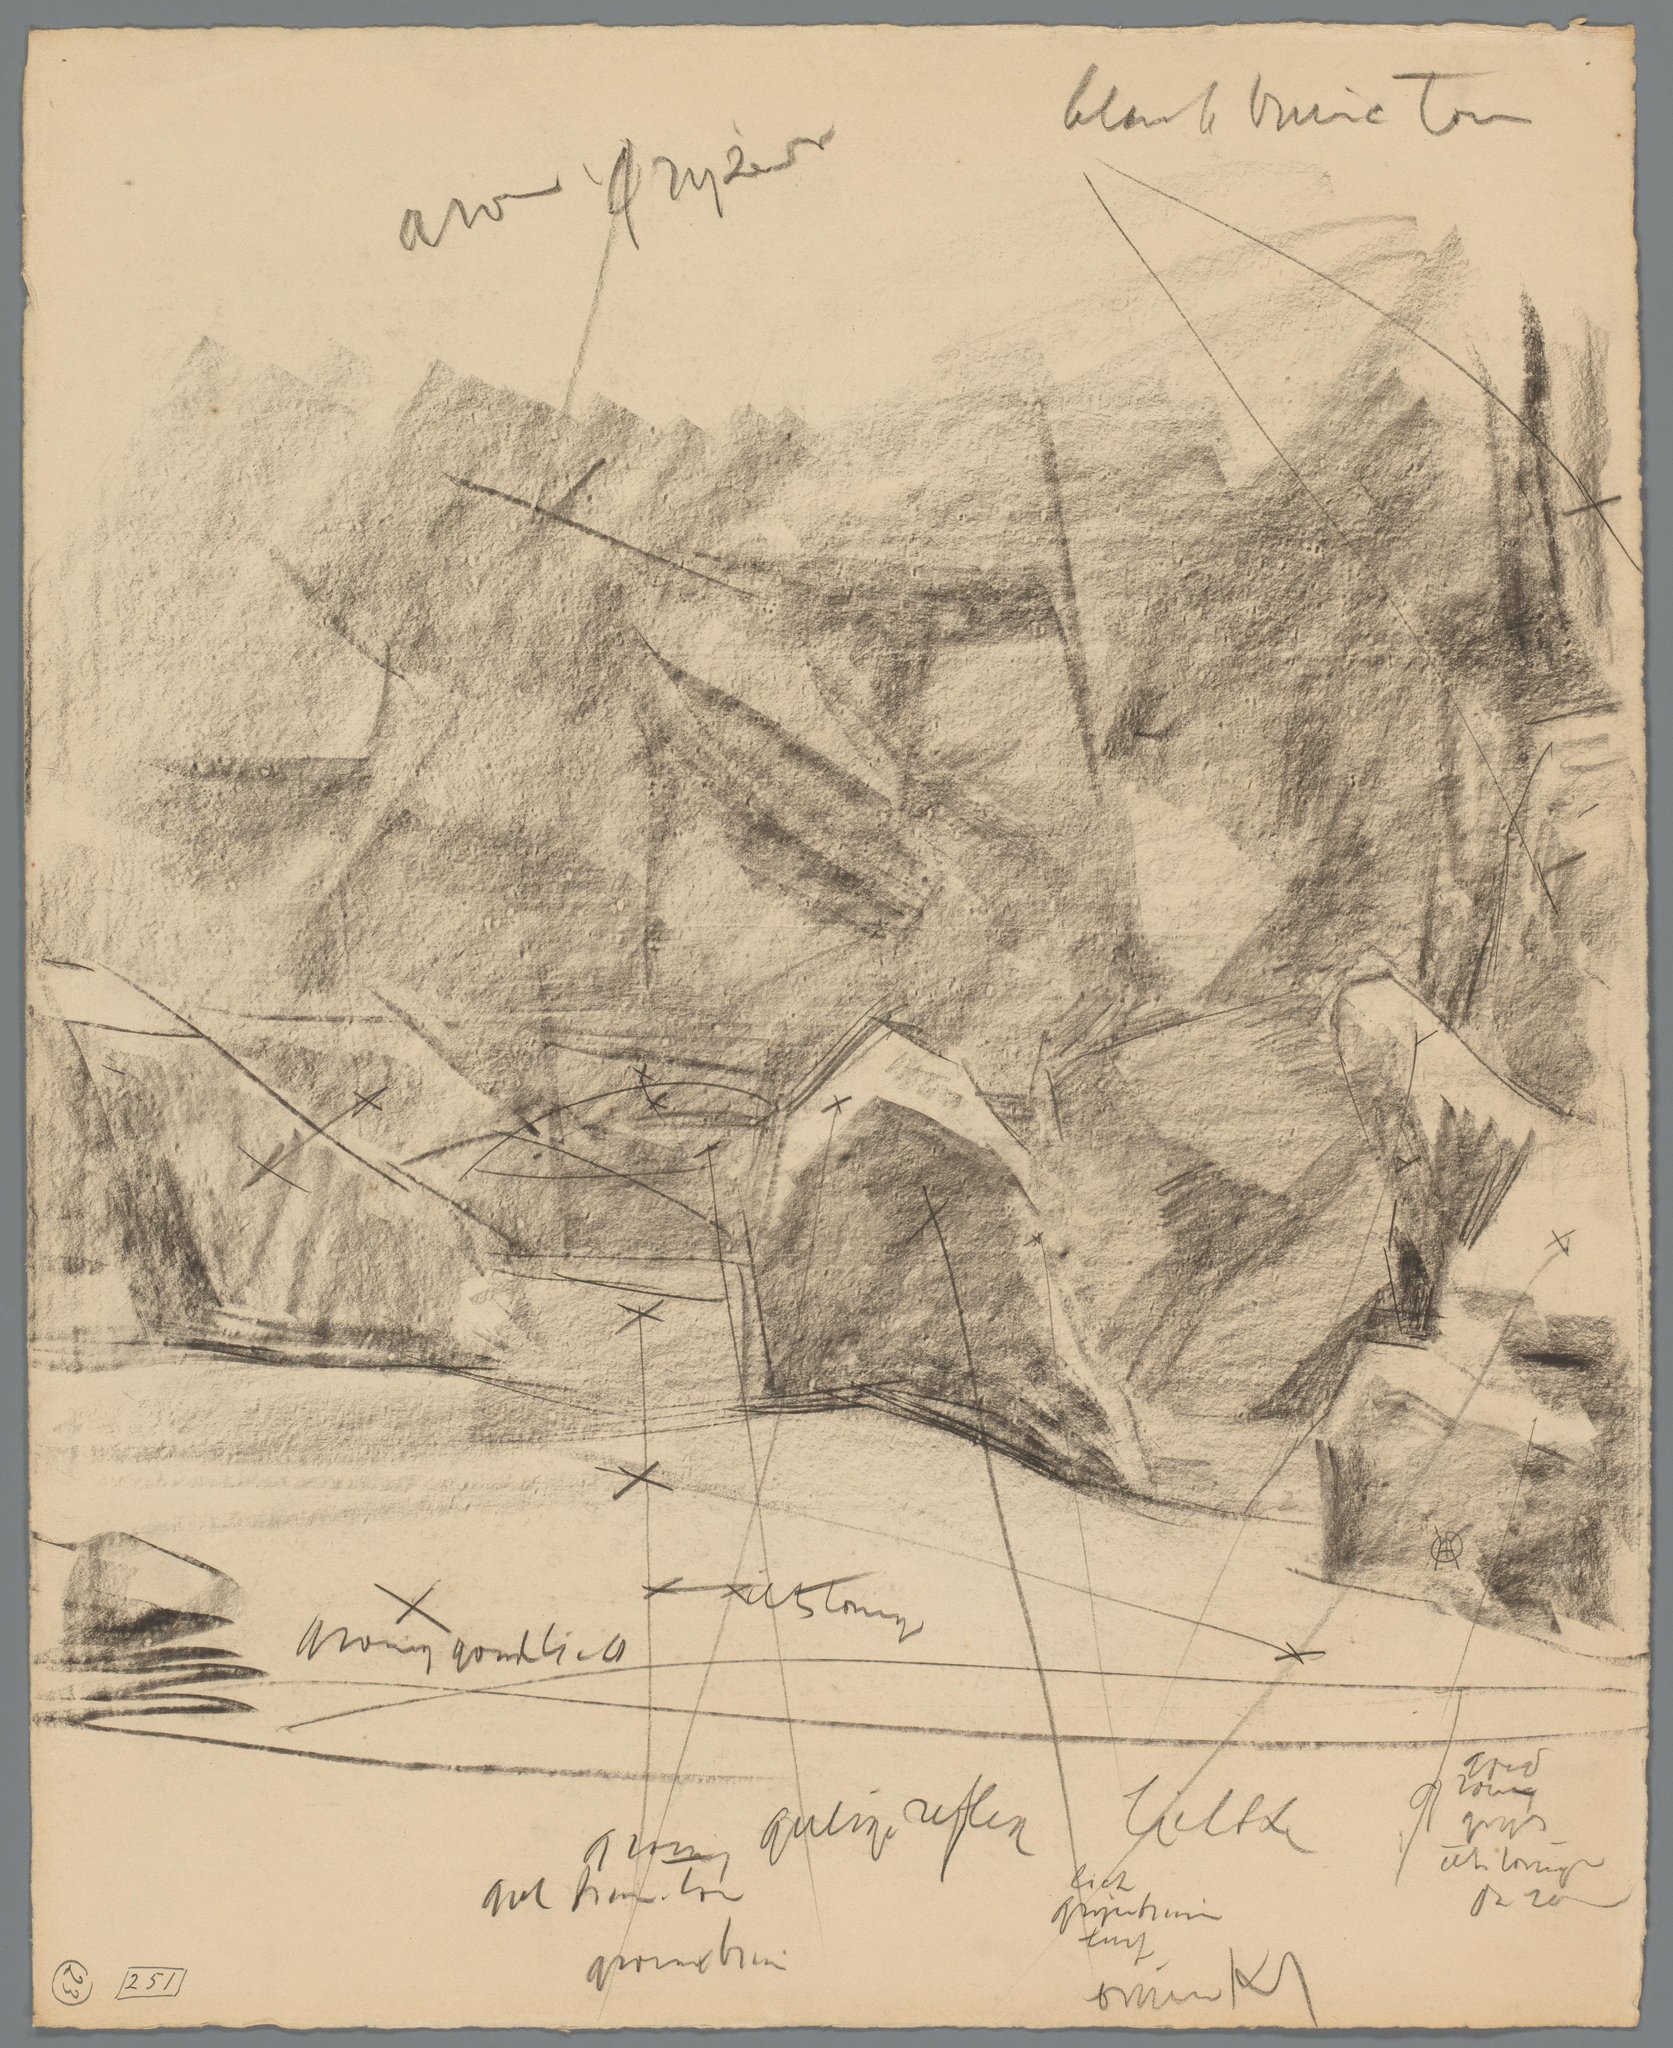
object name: drawing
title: Studie van een aquarium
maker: gerrit willem dijsselhof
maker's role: designer, draughtsman, print maker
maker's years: 1866-1924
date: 1876-1924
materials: chalk, paper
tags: aquarium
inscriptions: number: ‘23’, number: ‘251’